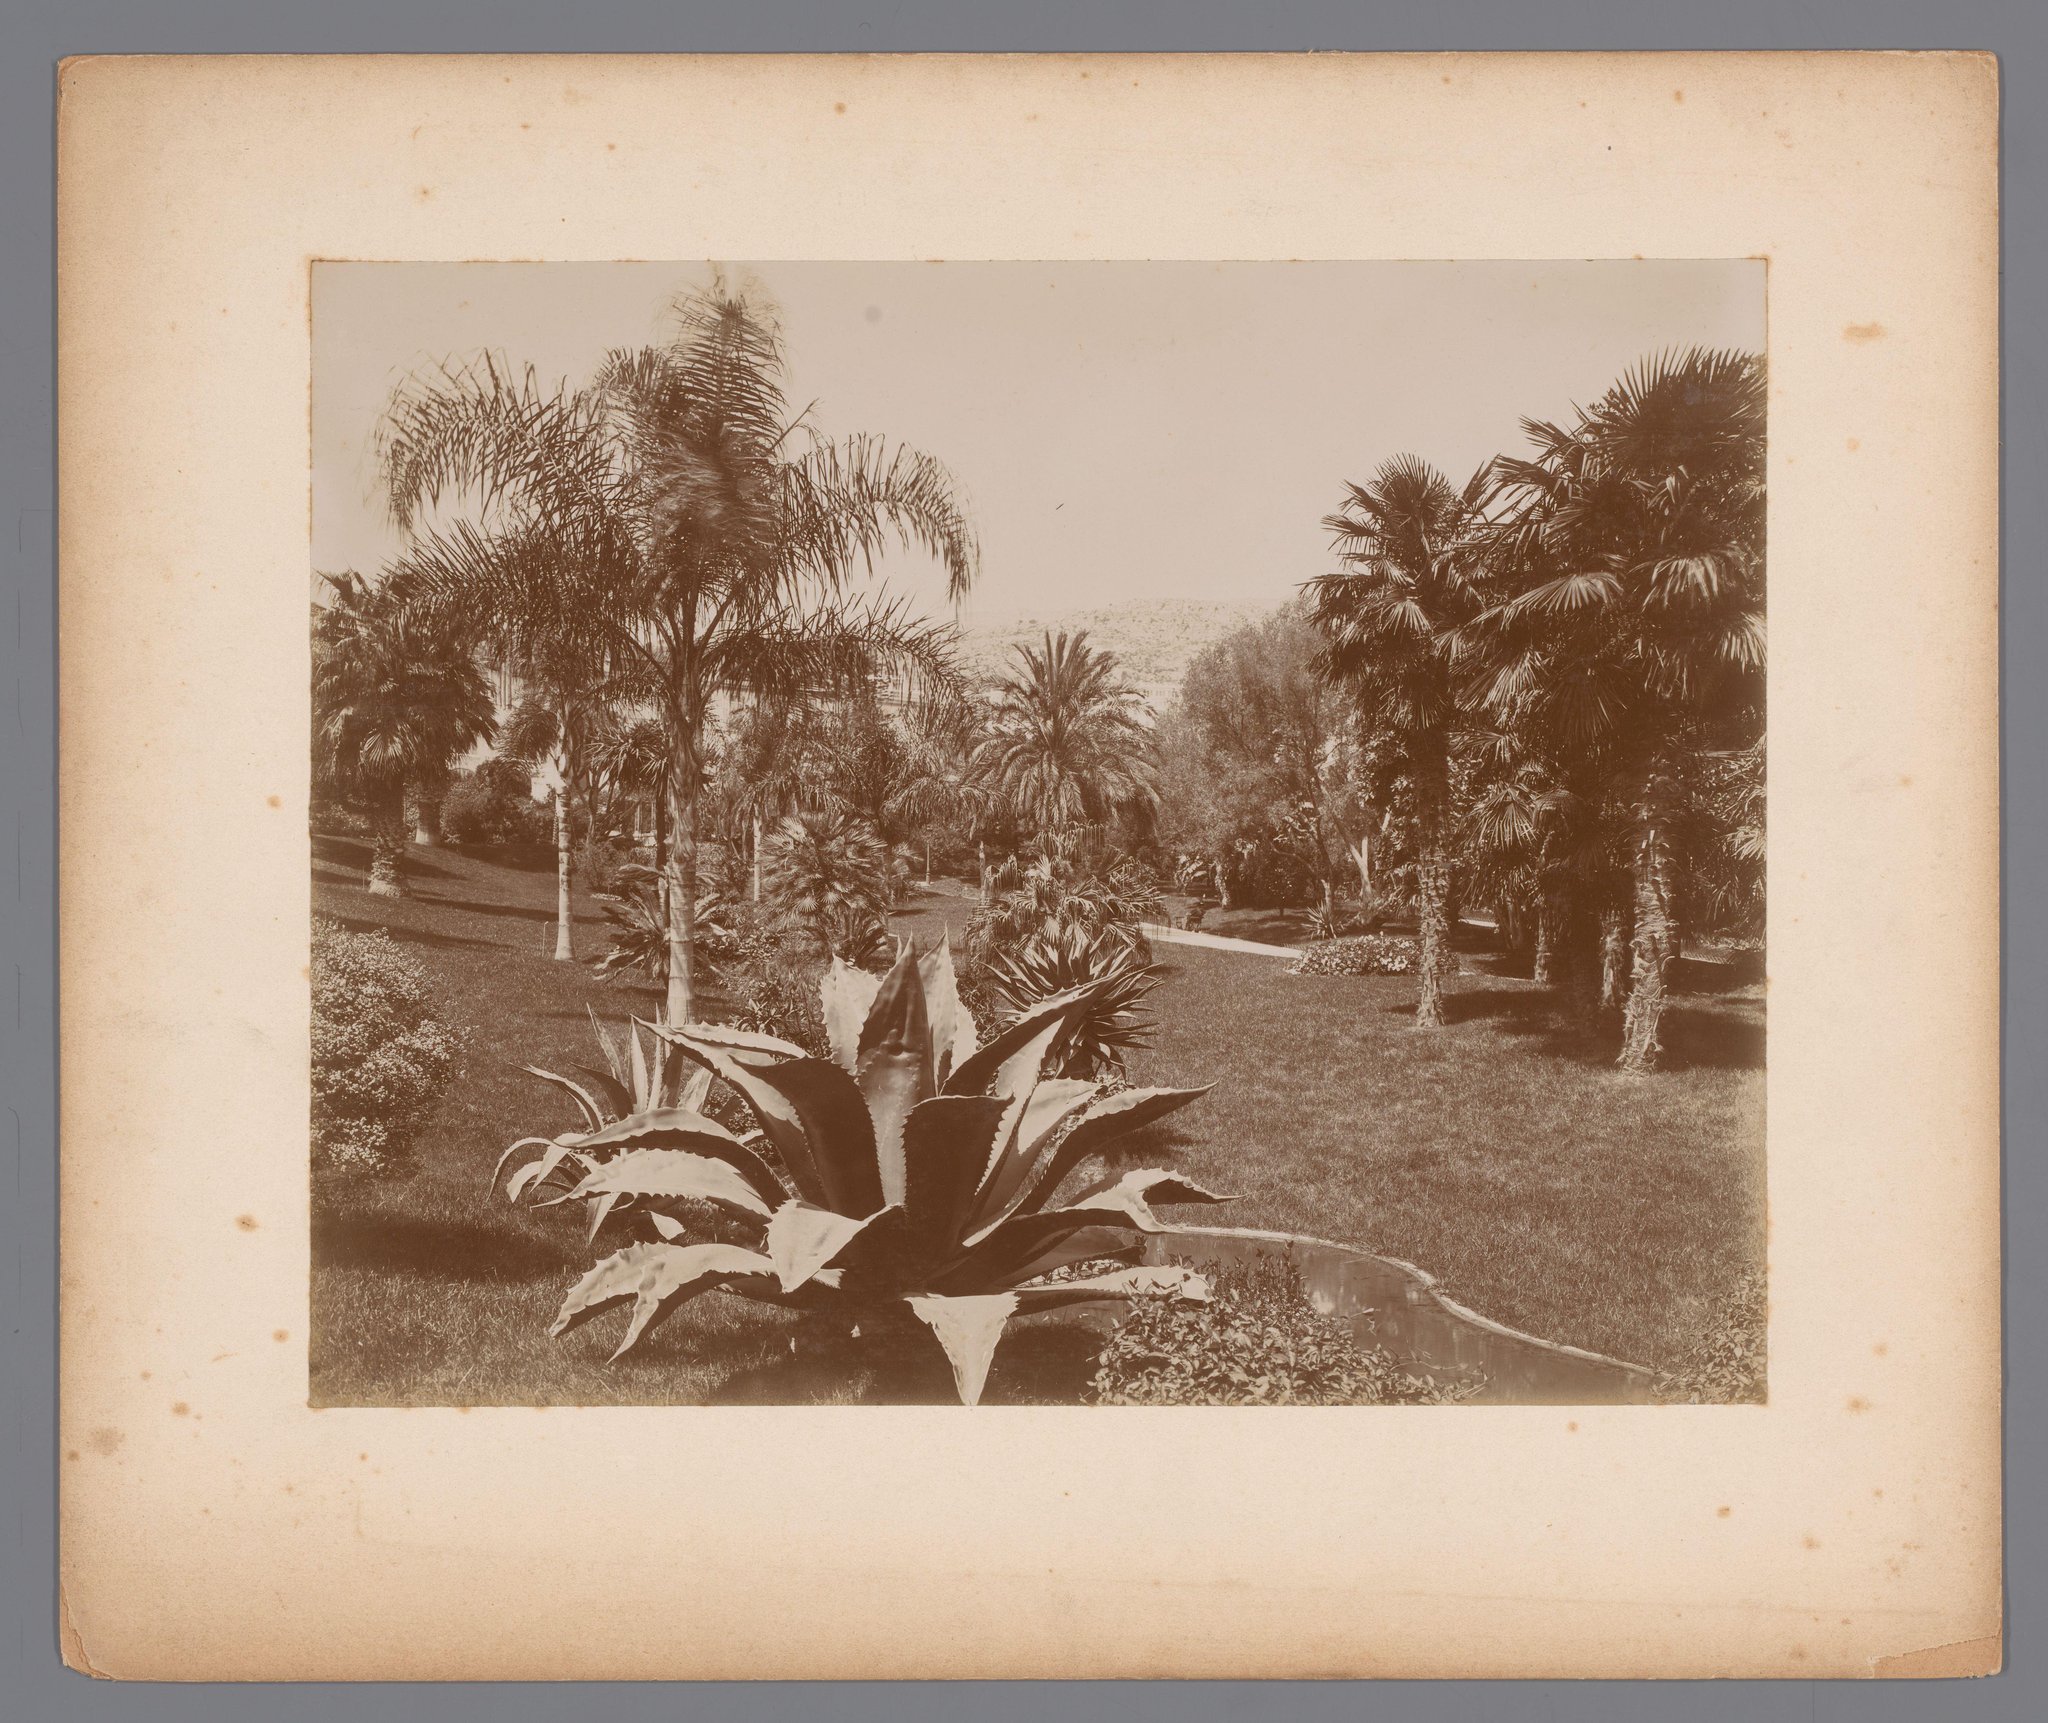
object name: photograph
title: Landschap met tropische vegetatie als palmen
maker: Anonymous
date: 1880-1910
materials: cardboard, paper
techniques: gelatin silver print